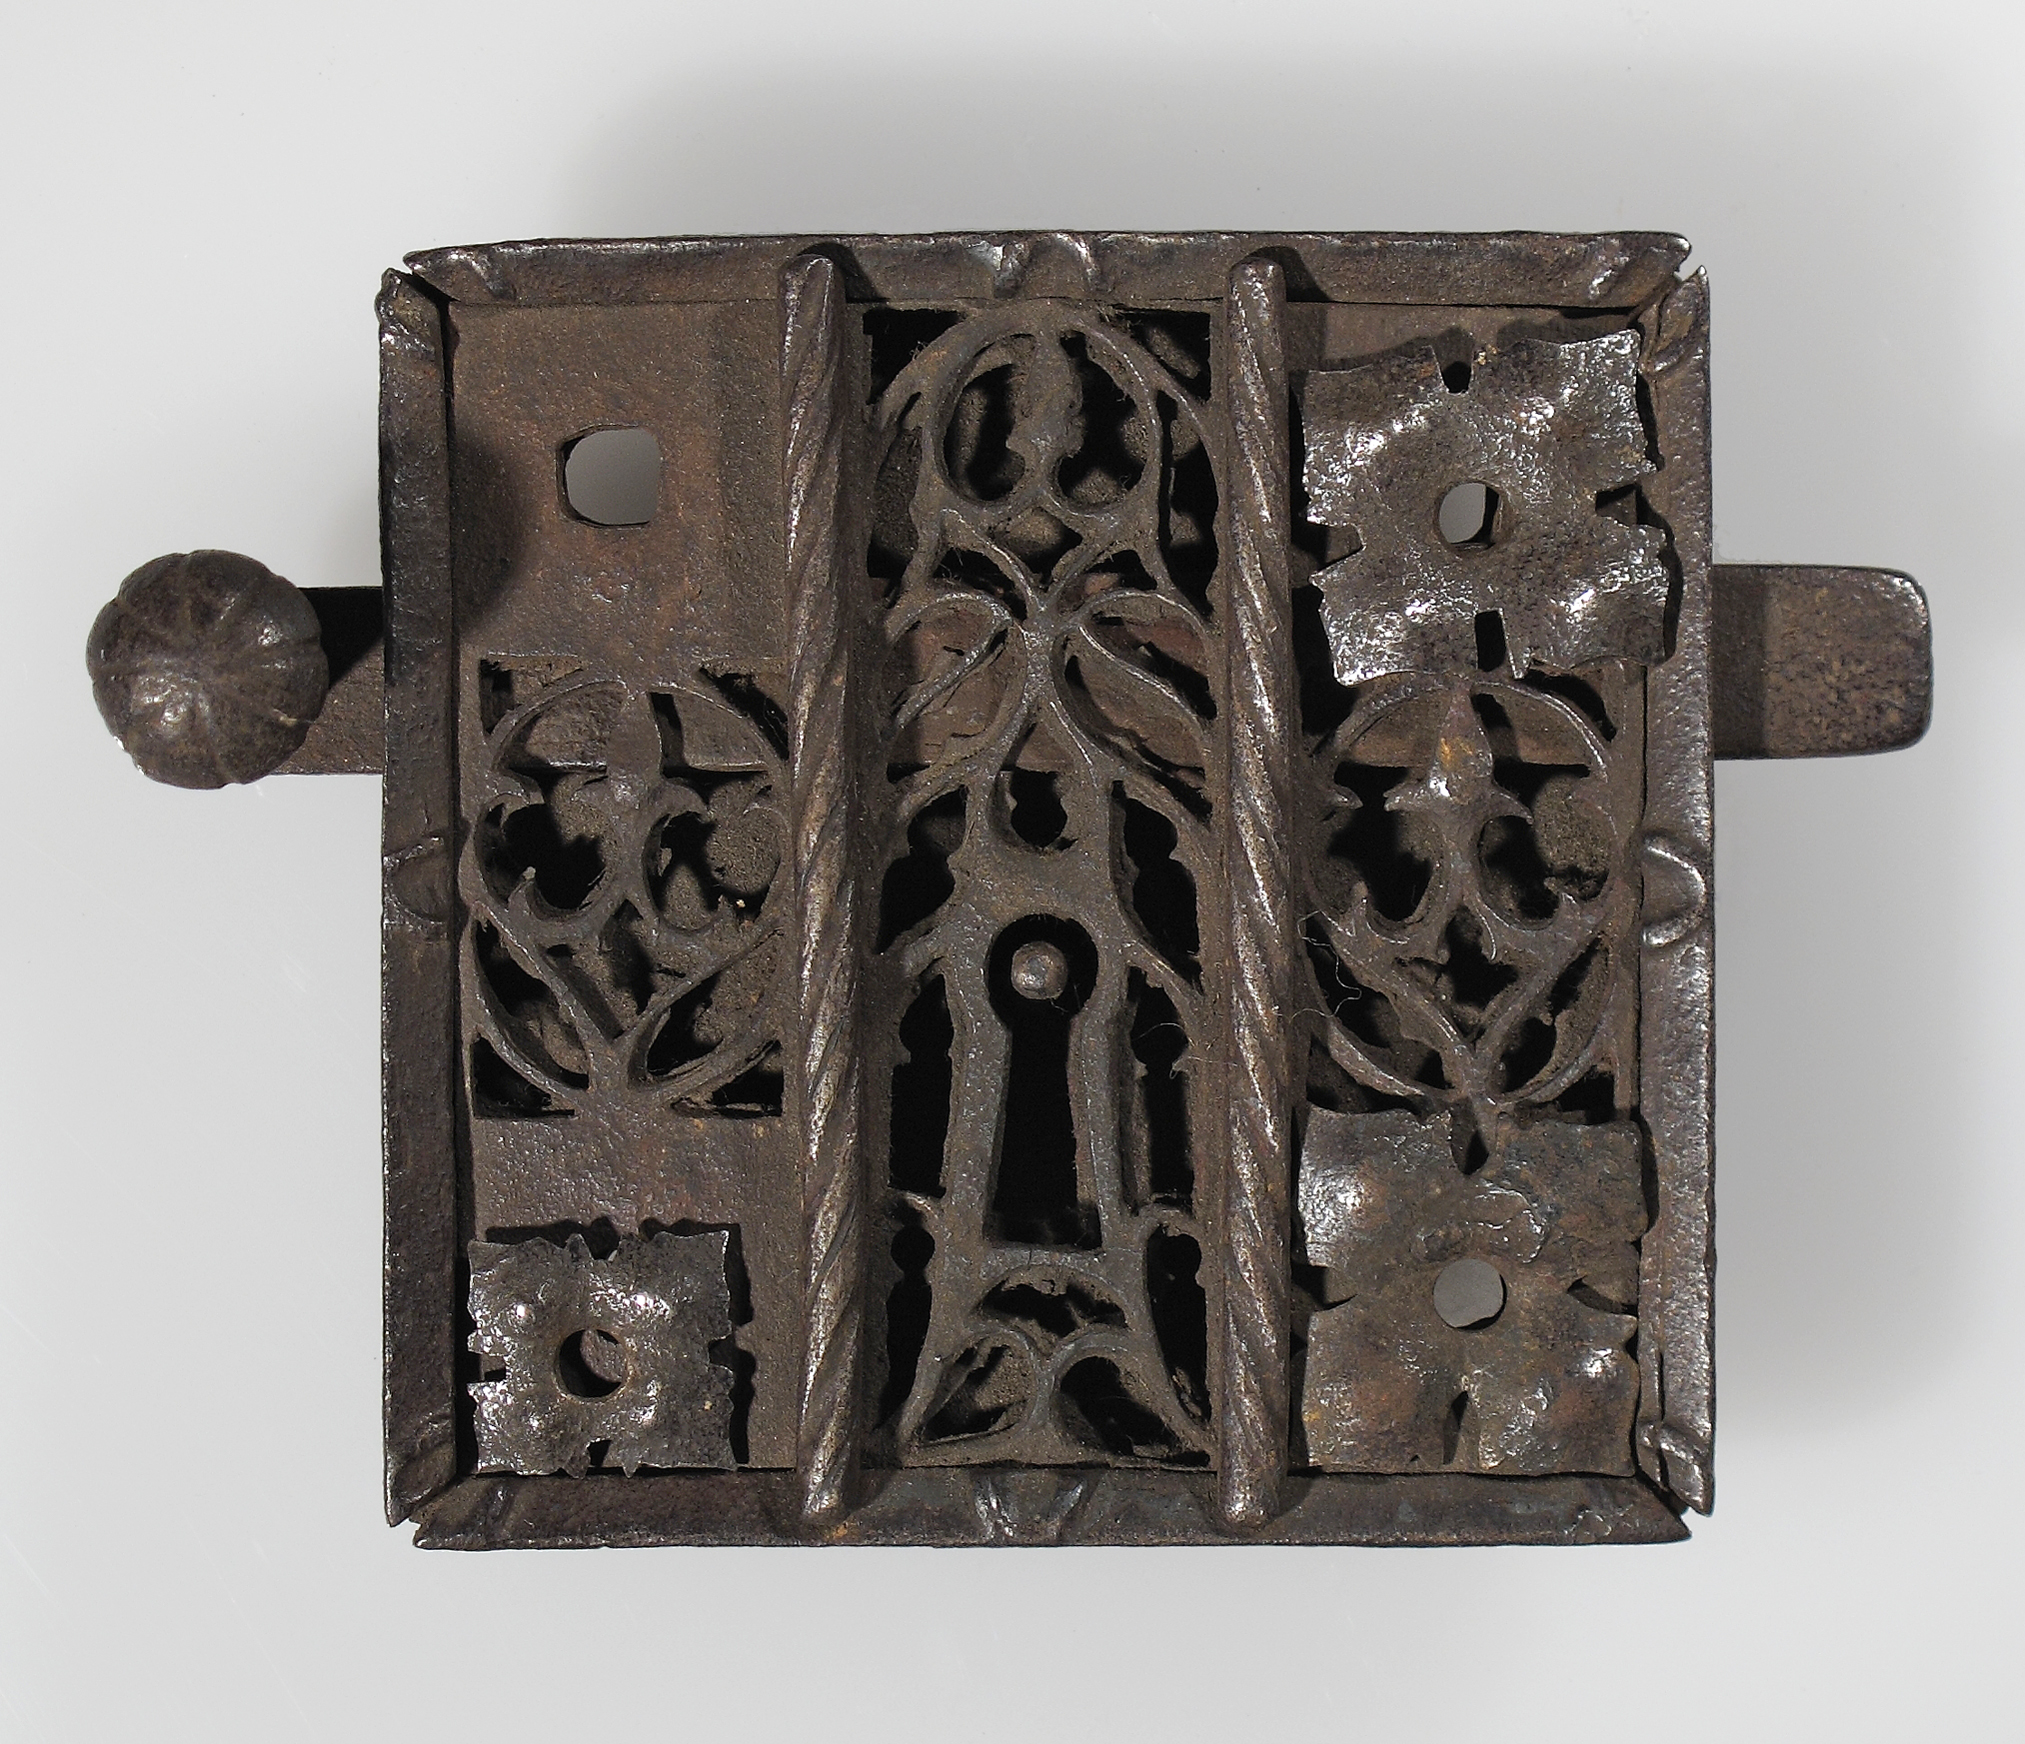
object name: lock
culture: european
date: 1401-1600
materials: iron